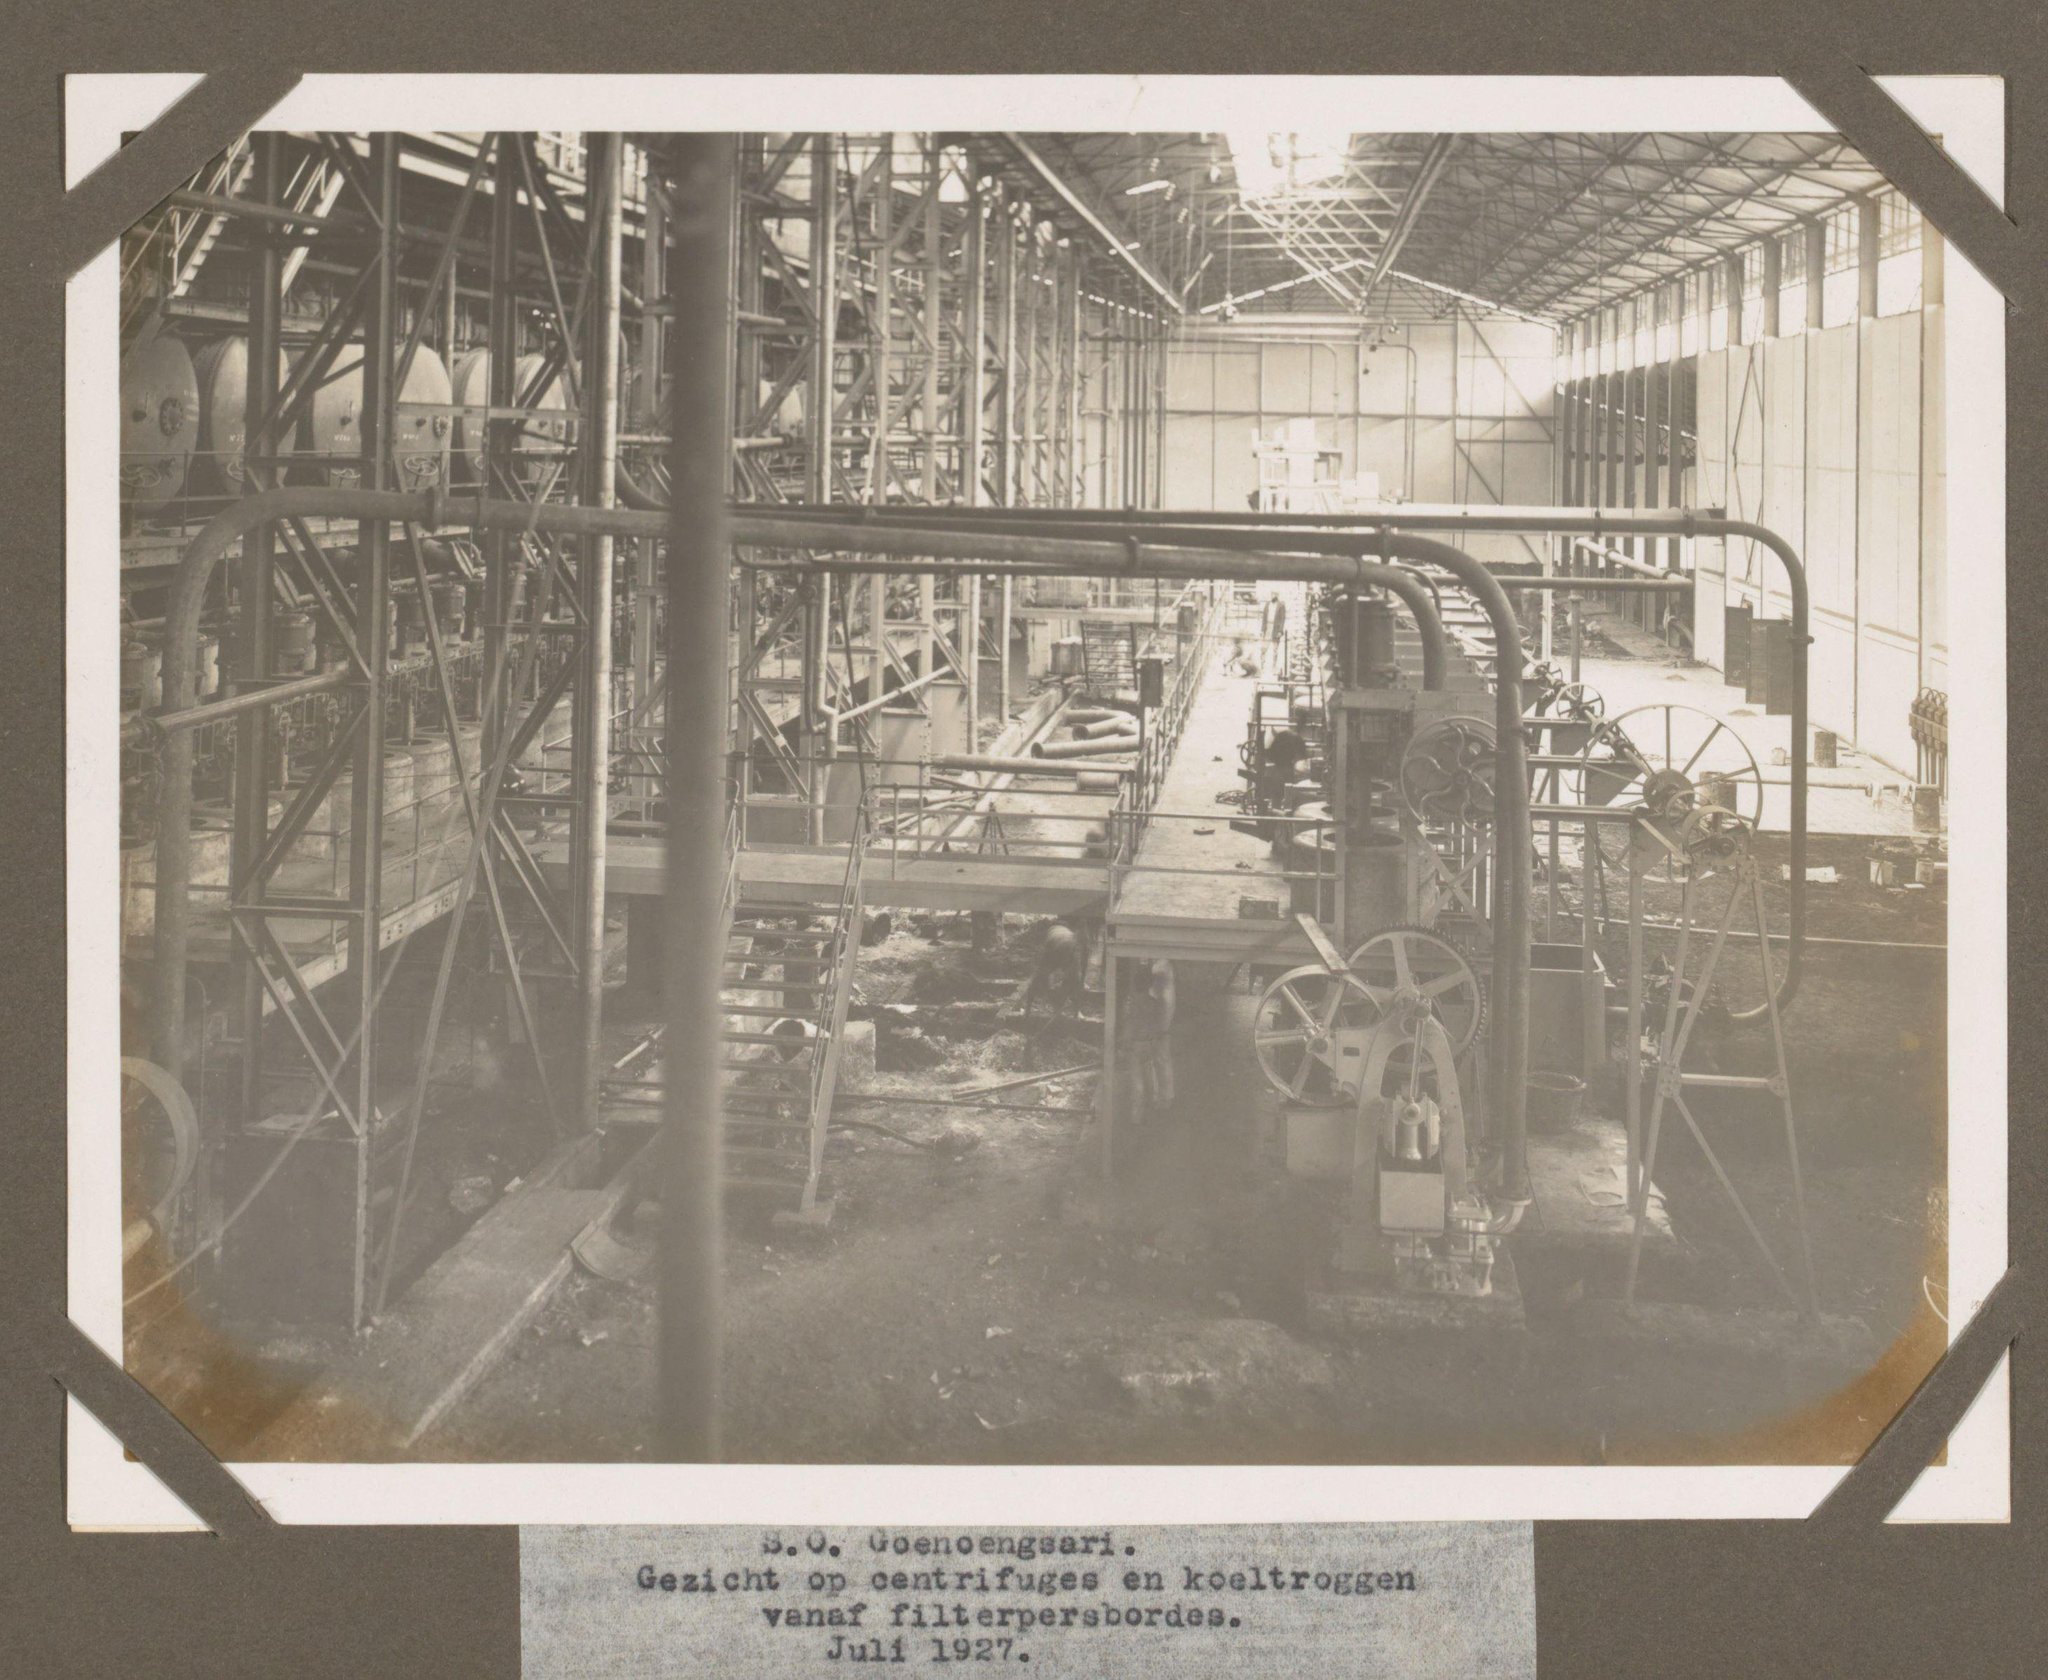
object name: photograph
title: S.O. Goenoengsari. Gezicht op centrifuges en koeltroggen vanaf filterpersbordes. Juli 1927.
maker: Anonymous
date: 1907-1927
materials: photographic support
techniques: gelatin silver print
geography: east java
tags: colonial system, trade-company, factory-interior, machine shop, making the overground structures (~ building activities), (non-fruit) products of plants or trees: sugarcane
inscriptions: inscription: ‘S.O. Goenoengsari. Gezicht op centrifuges en koeltroggen vanaf filterpersbordes. Juli 1927.’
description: Fabriekshal met machines, juli 1927. Onderdeel van het fotoalbum met foto's van de opbouw van de suikerfabriek te Goenoengsari op Oost-Java door de Handels Vereniging Amsterdam 1926-1927.